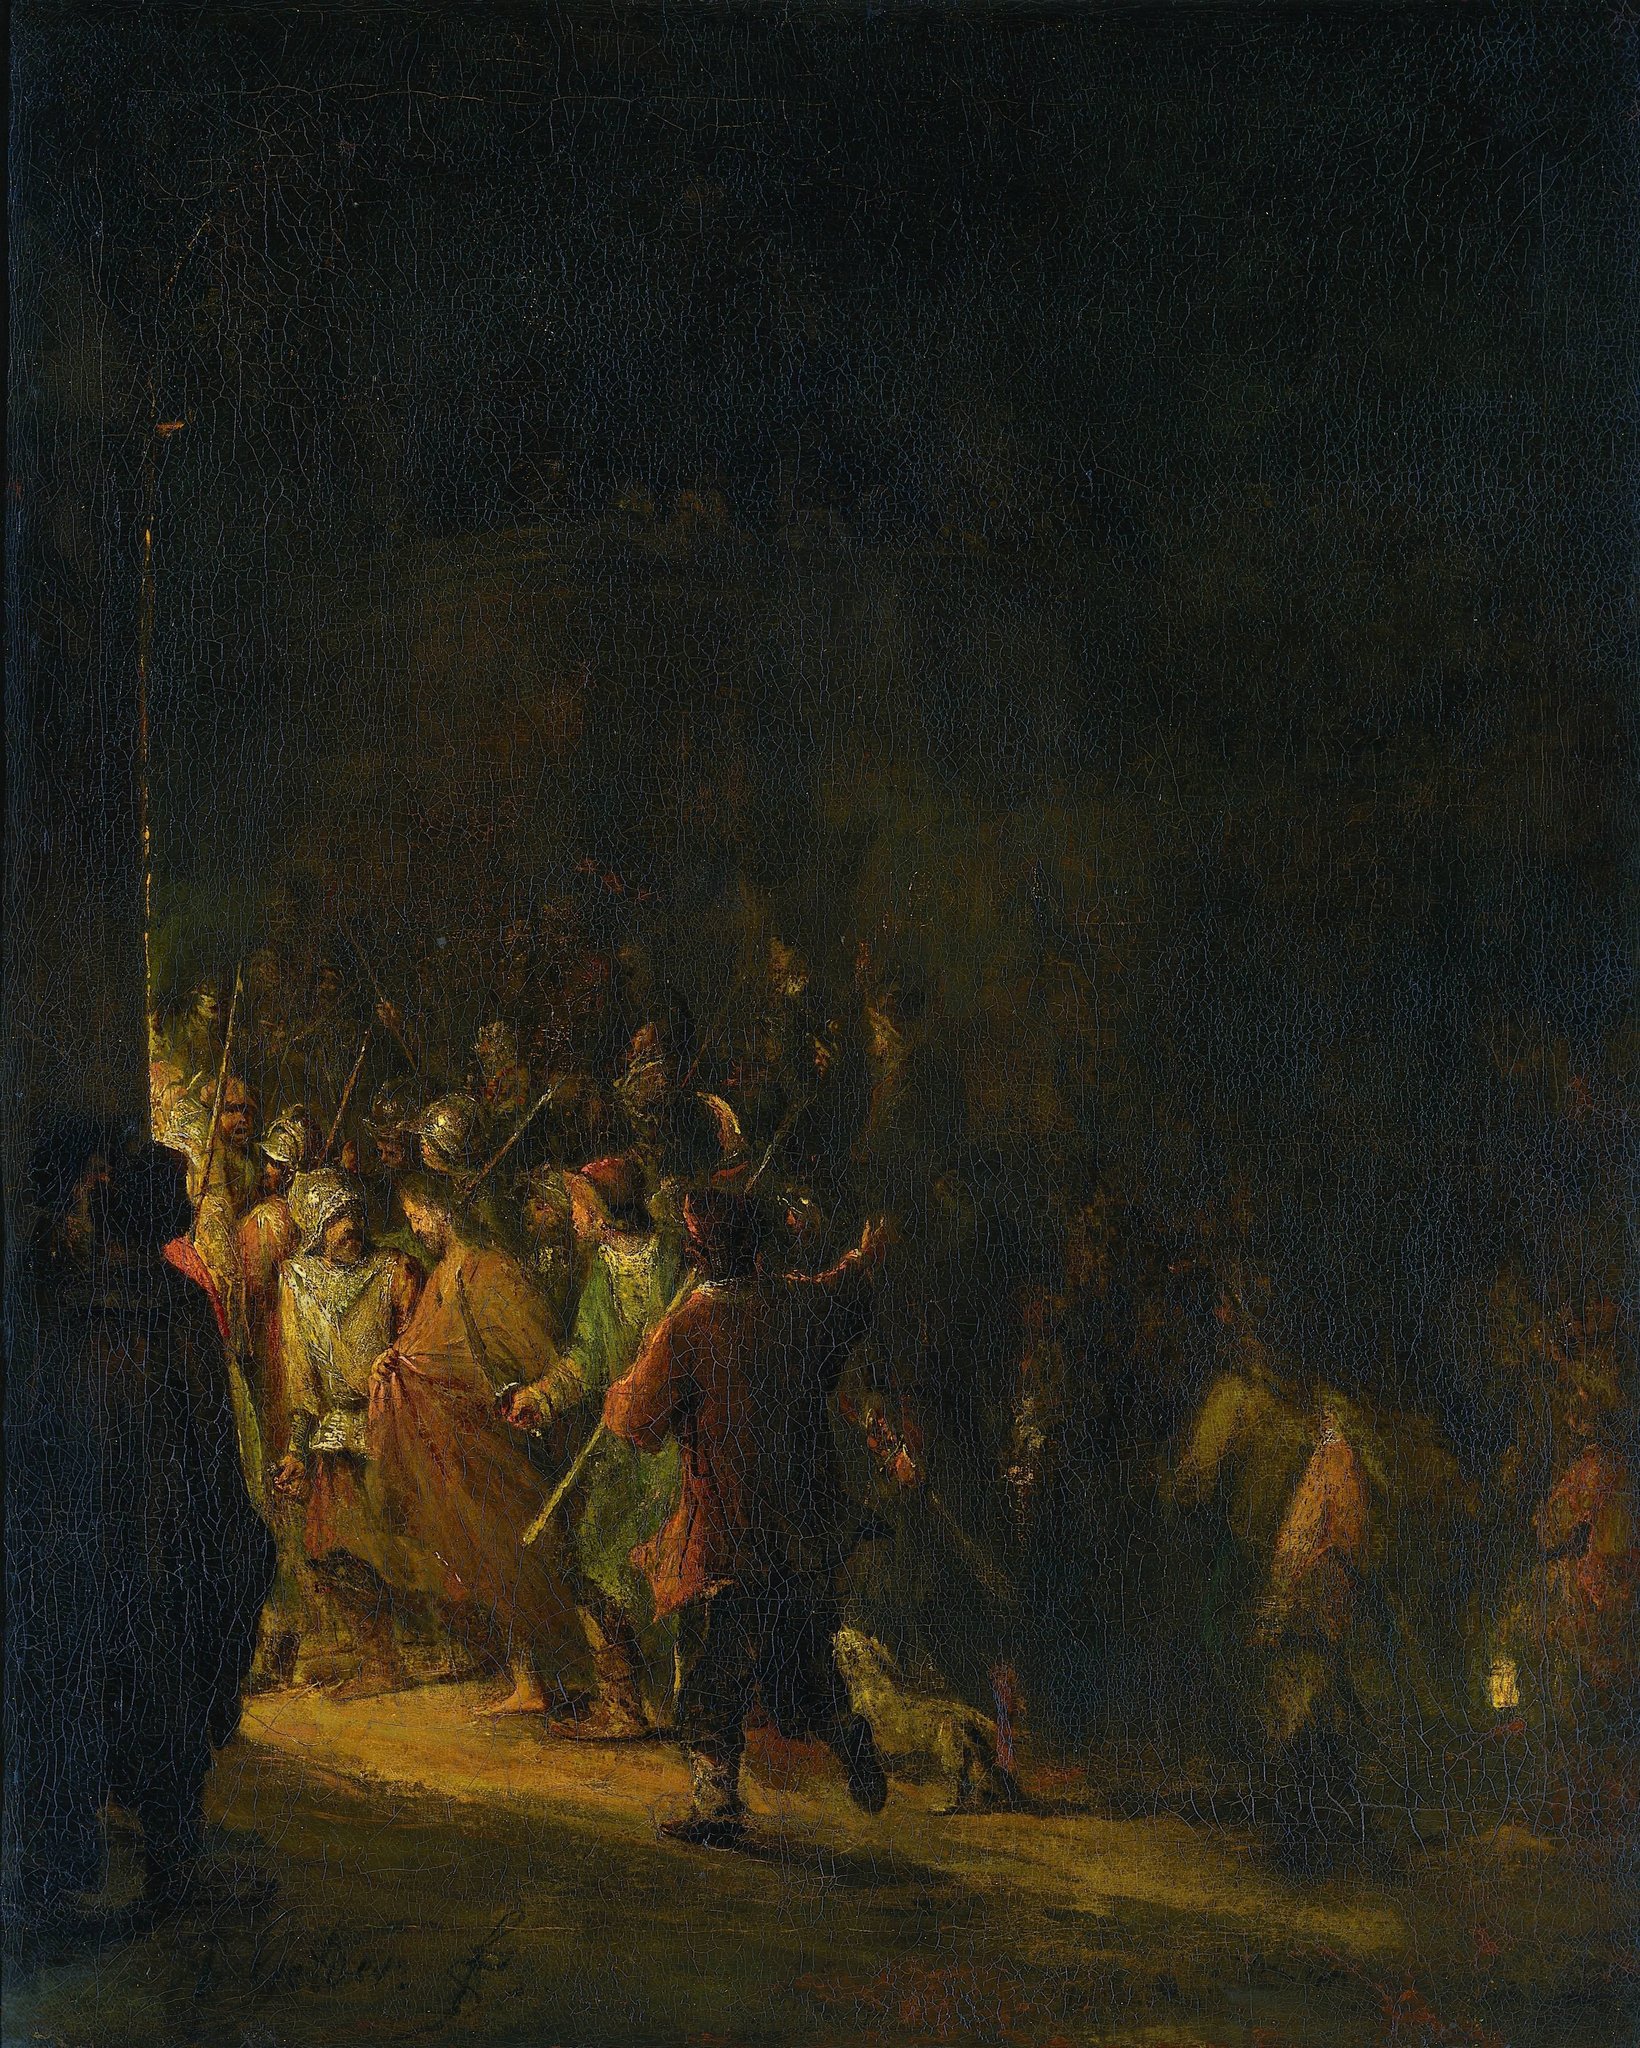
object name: painting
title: The Arrest of Christ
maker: aert de gelder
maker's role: draughtsman, painter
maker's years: 1645-1727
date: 1710-1727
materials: canvas, oil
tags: christ is led away ~ garden of gethsemane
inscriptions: signature: ‘ADe Gelder f.’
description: De gevangenneming van Christus. Nachtscène met links Christus tussen een groep gewapende soldaten. Op de achtergrond een hoge muur. Behoort samen met SK-A-2360 tot een reeks van passievoorstellingen waarvan de andere delen zich bevinden in Aschaffenburg.